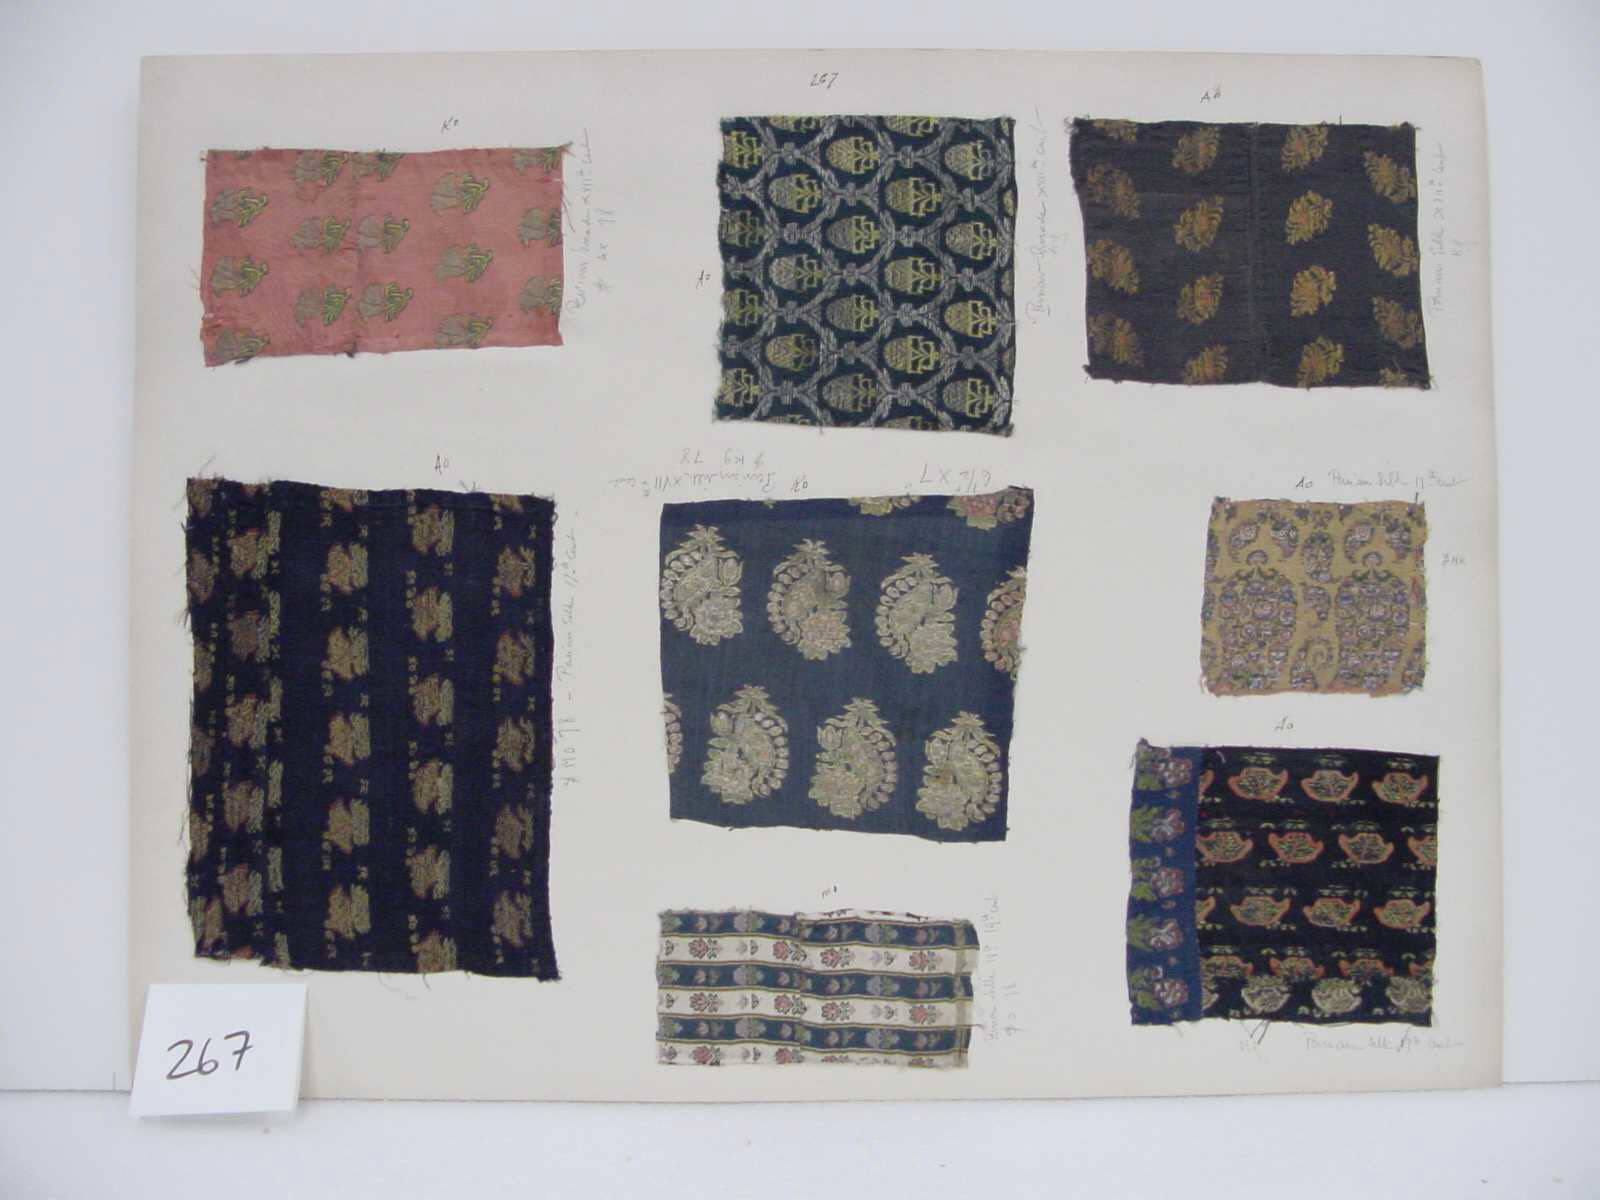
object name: textile fragment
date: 1601-1700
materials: metal thread, silk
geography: iran